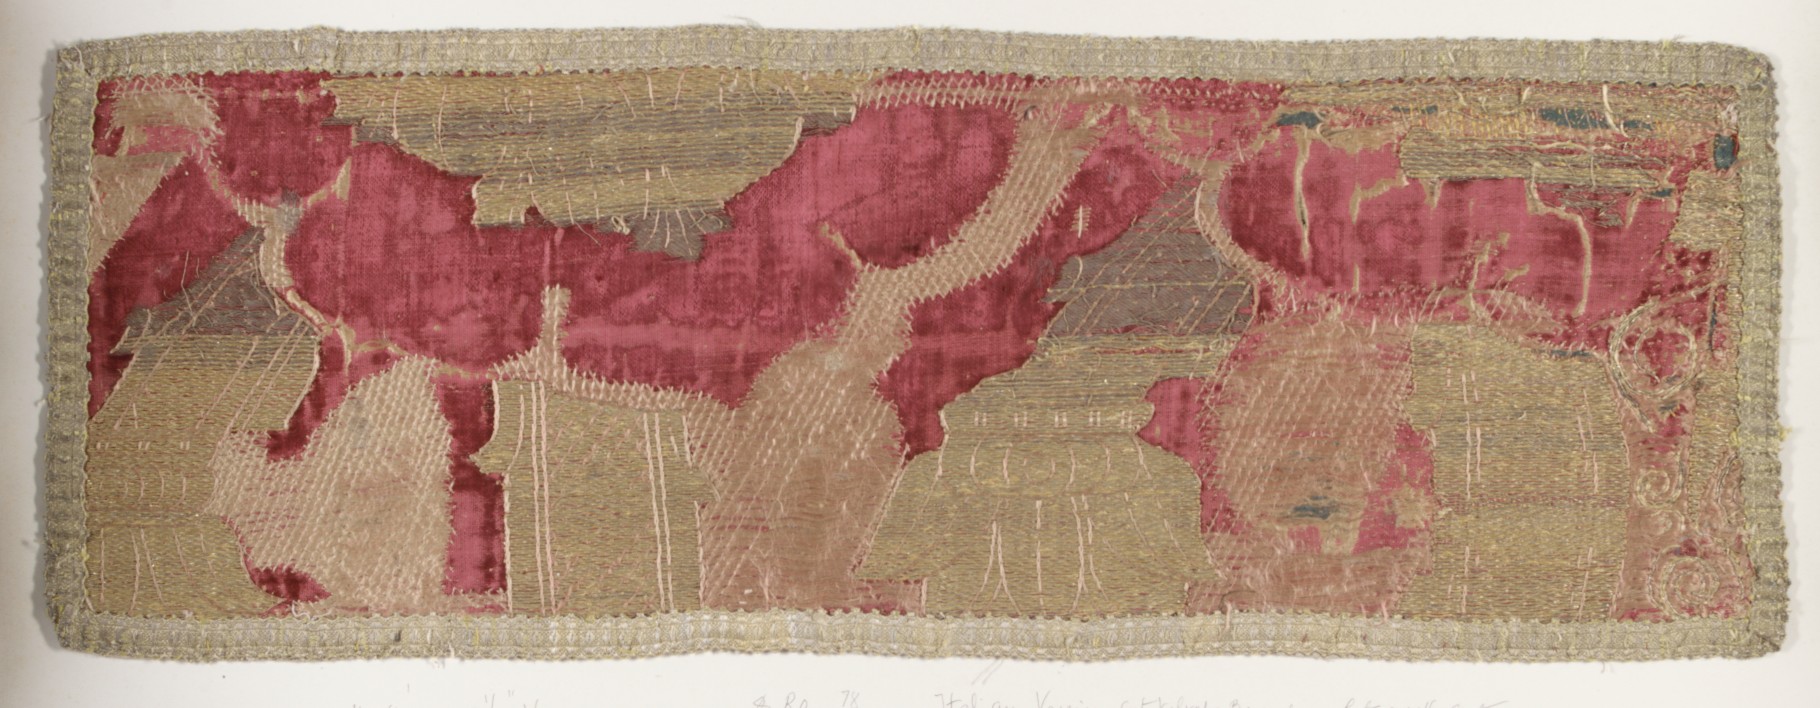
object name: fragment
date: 1467-1500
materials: metal thread, silk